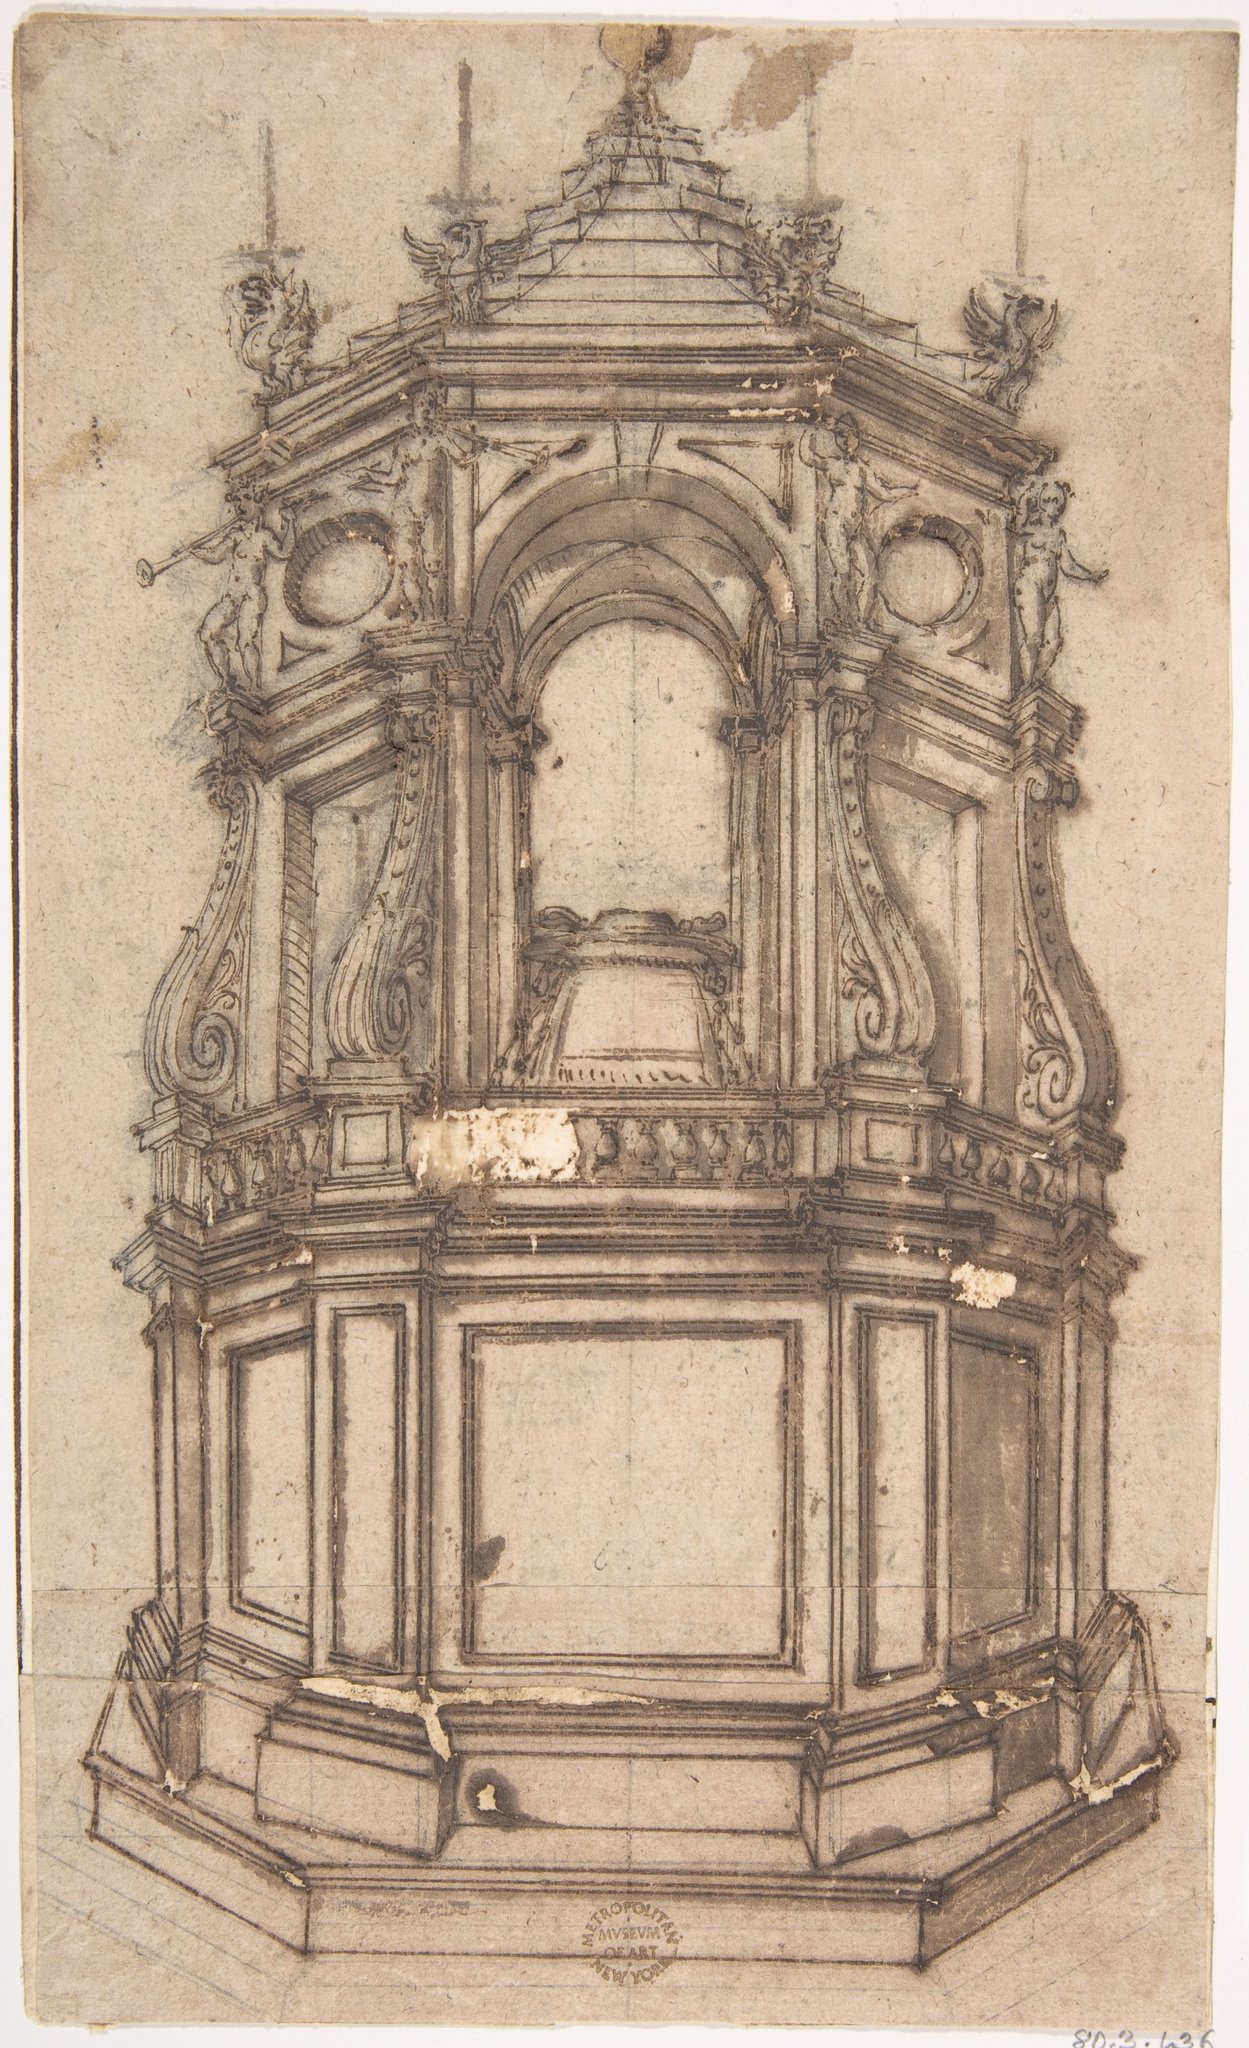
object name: drawing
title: Catafalque for a Cardinal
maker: anonymous, italian, roman-bolognese, 17th century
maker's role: artist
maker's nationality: italian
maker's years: 1600-1700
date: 1601-1700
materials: chalk, ink, paper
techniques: brush, pen, wash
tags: birds,architecture,female nudes